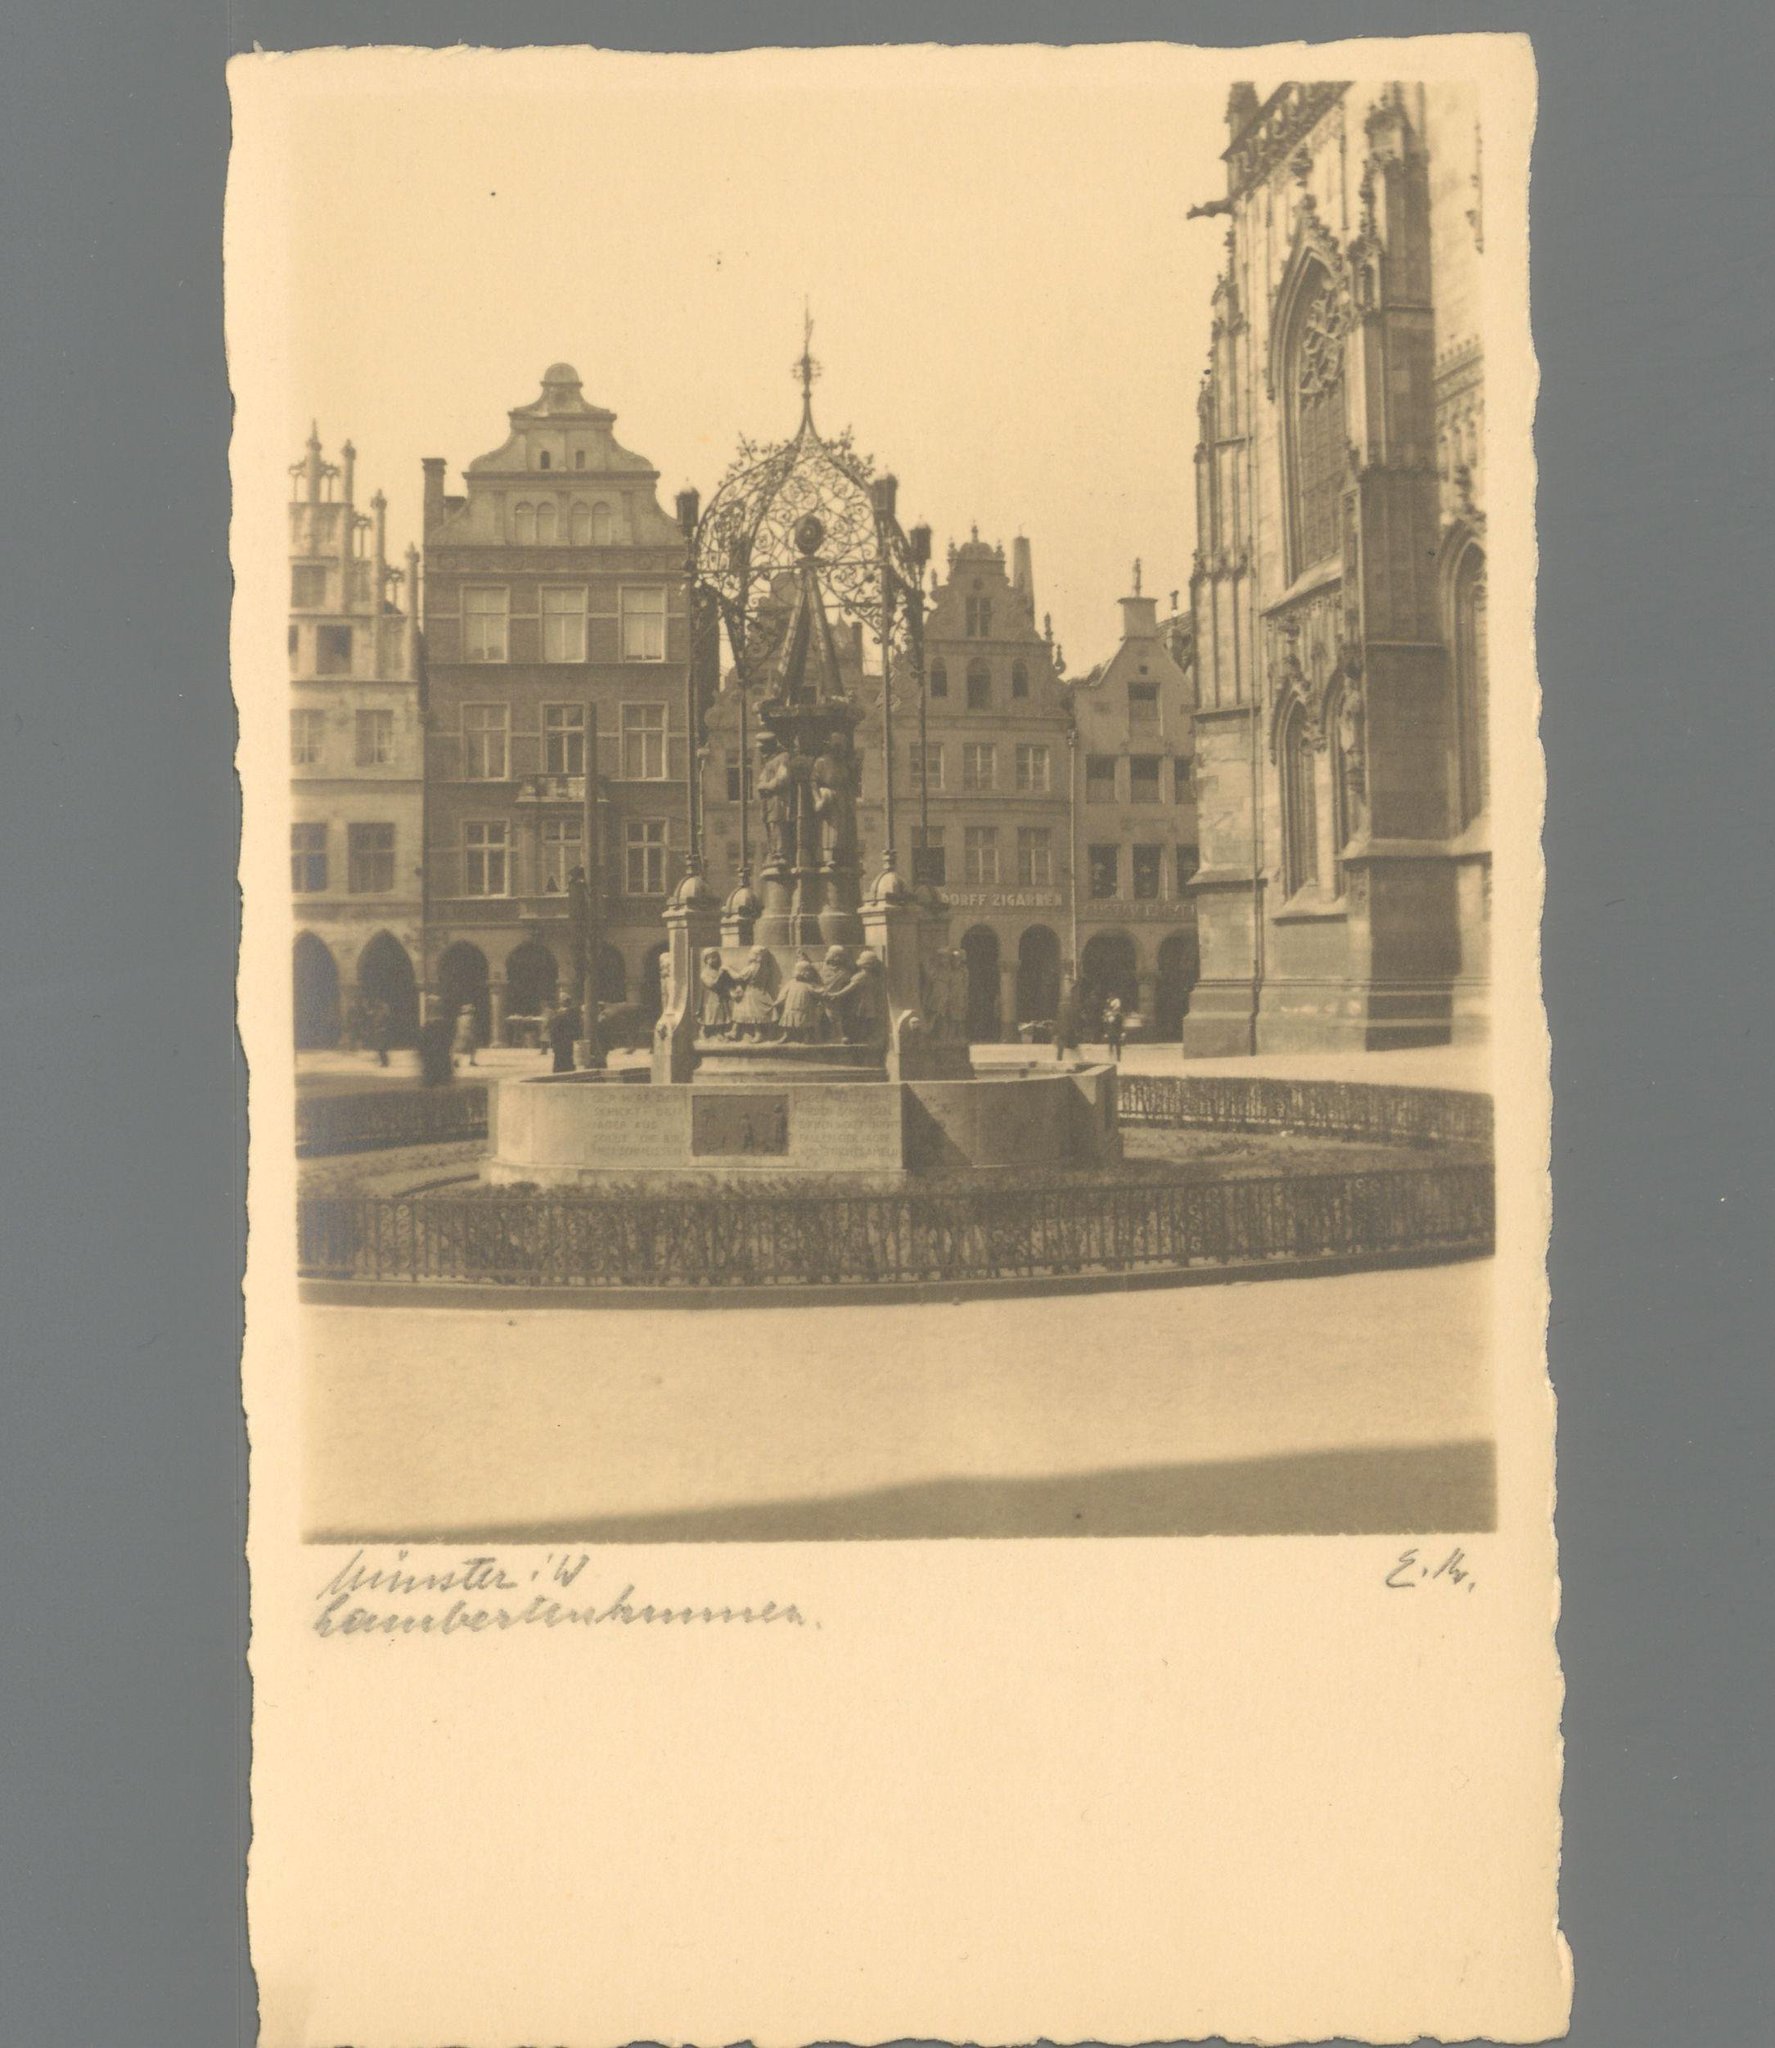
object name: ansichtkaart, prentbriefkaart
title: Gezicht op de Lambertibrunnen te Münster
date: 1905-1930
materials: photographic support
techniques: gelatin silver print, writing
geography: munster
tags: ornamental fountain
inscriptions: monogram: ‘M’, inscription: ‘E.[R].’